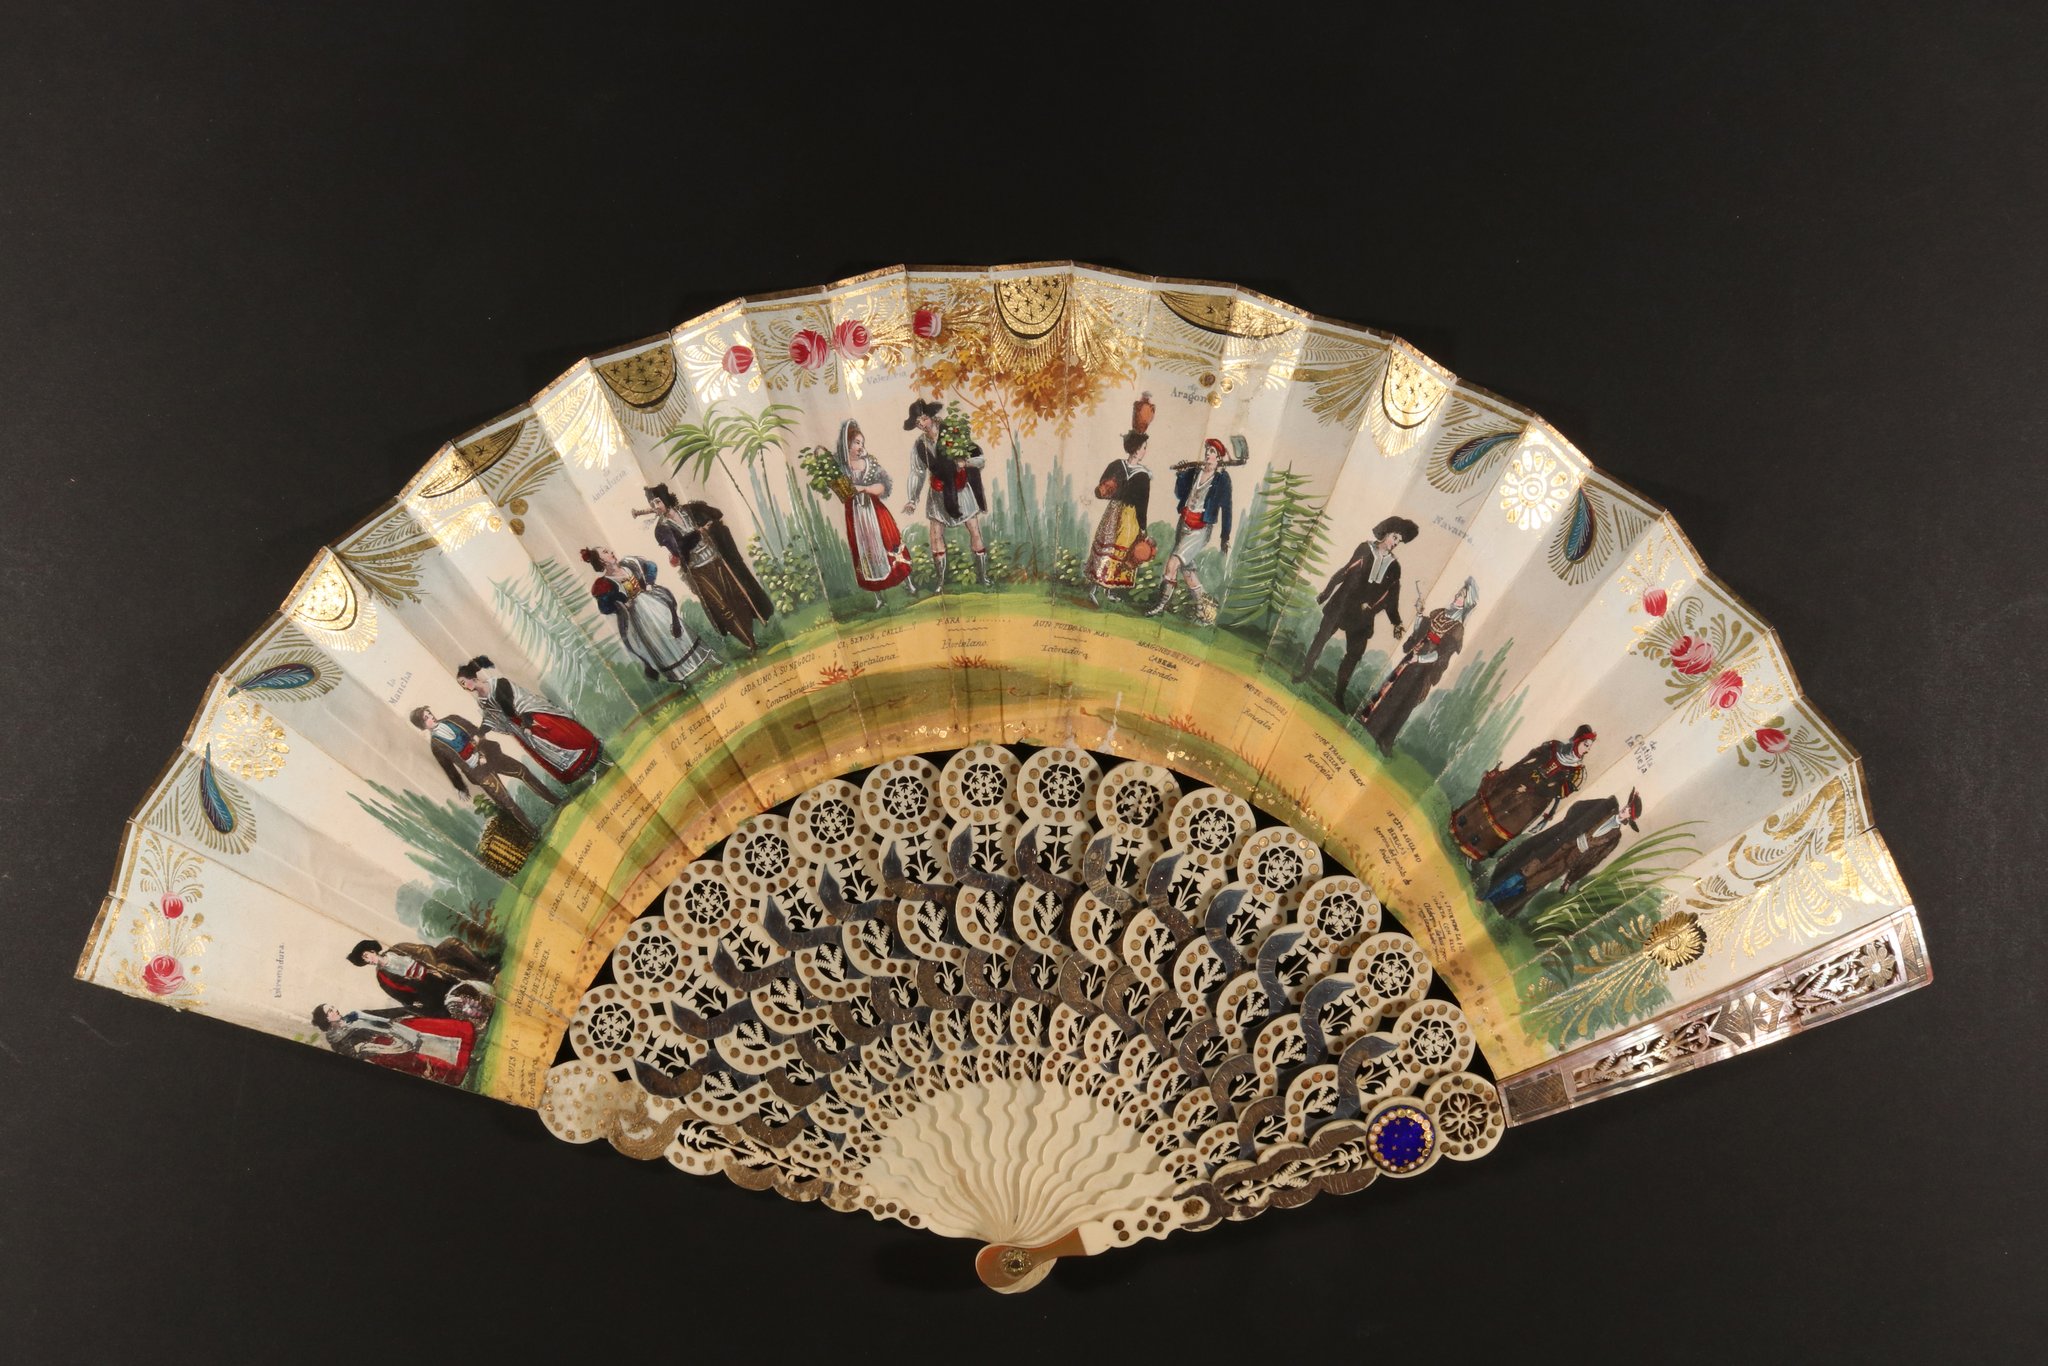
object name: fan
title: Fan with depiction of Spanish folk costume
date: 1801-1833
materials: enamel, gold leaf, ivory, metal, mother of pearl, paper, parchment, silver, silver gilt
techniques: hand coloring, lithograph, painting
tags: men,women